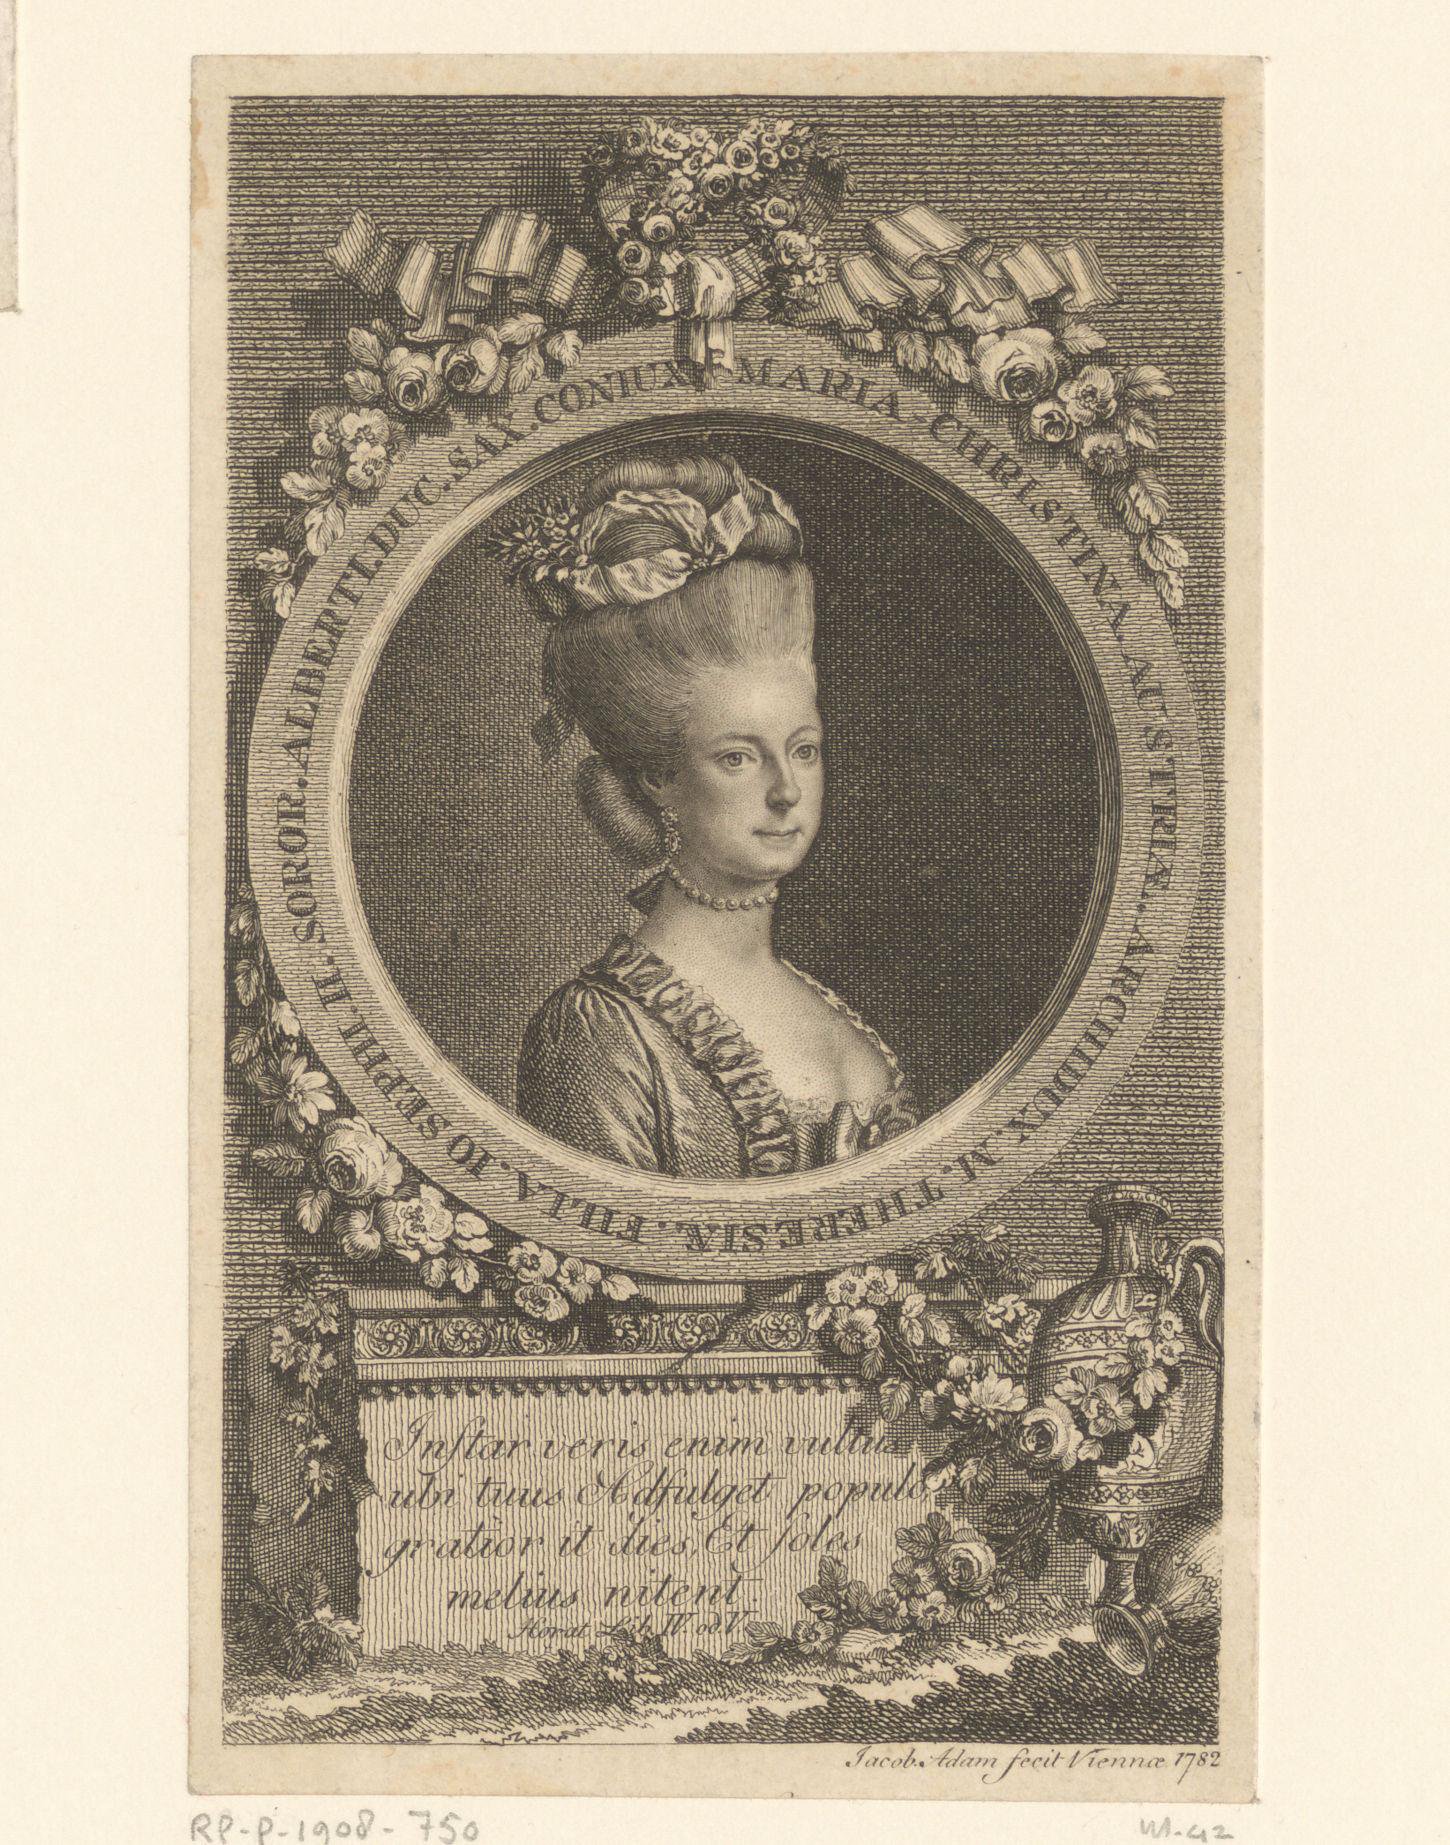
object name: print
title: Portret van Maria Christina van Oostenrijk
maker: jakob adam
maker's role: print maker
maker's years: 1748-1811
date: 1782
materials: paper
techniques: etching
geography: vienna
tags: historical persons - bb - woman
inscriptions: collector's mark: Lugt 2228